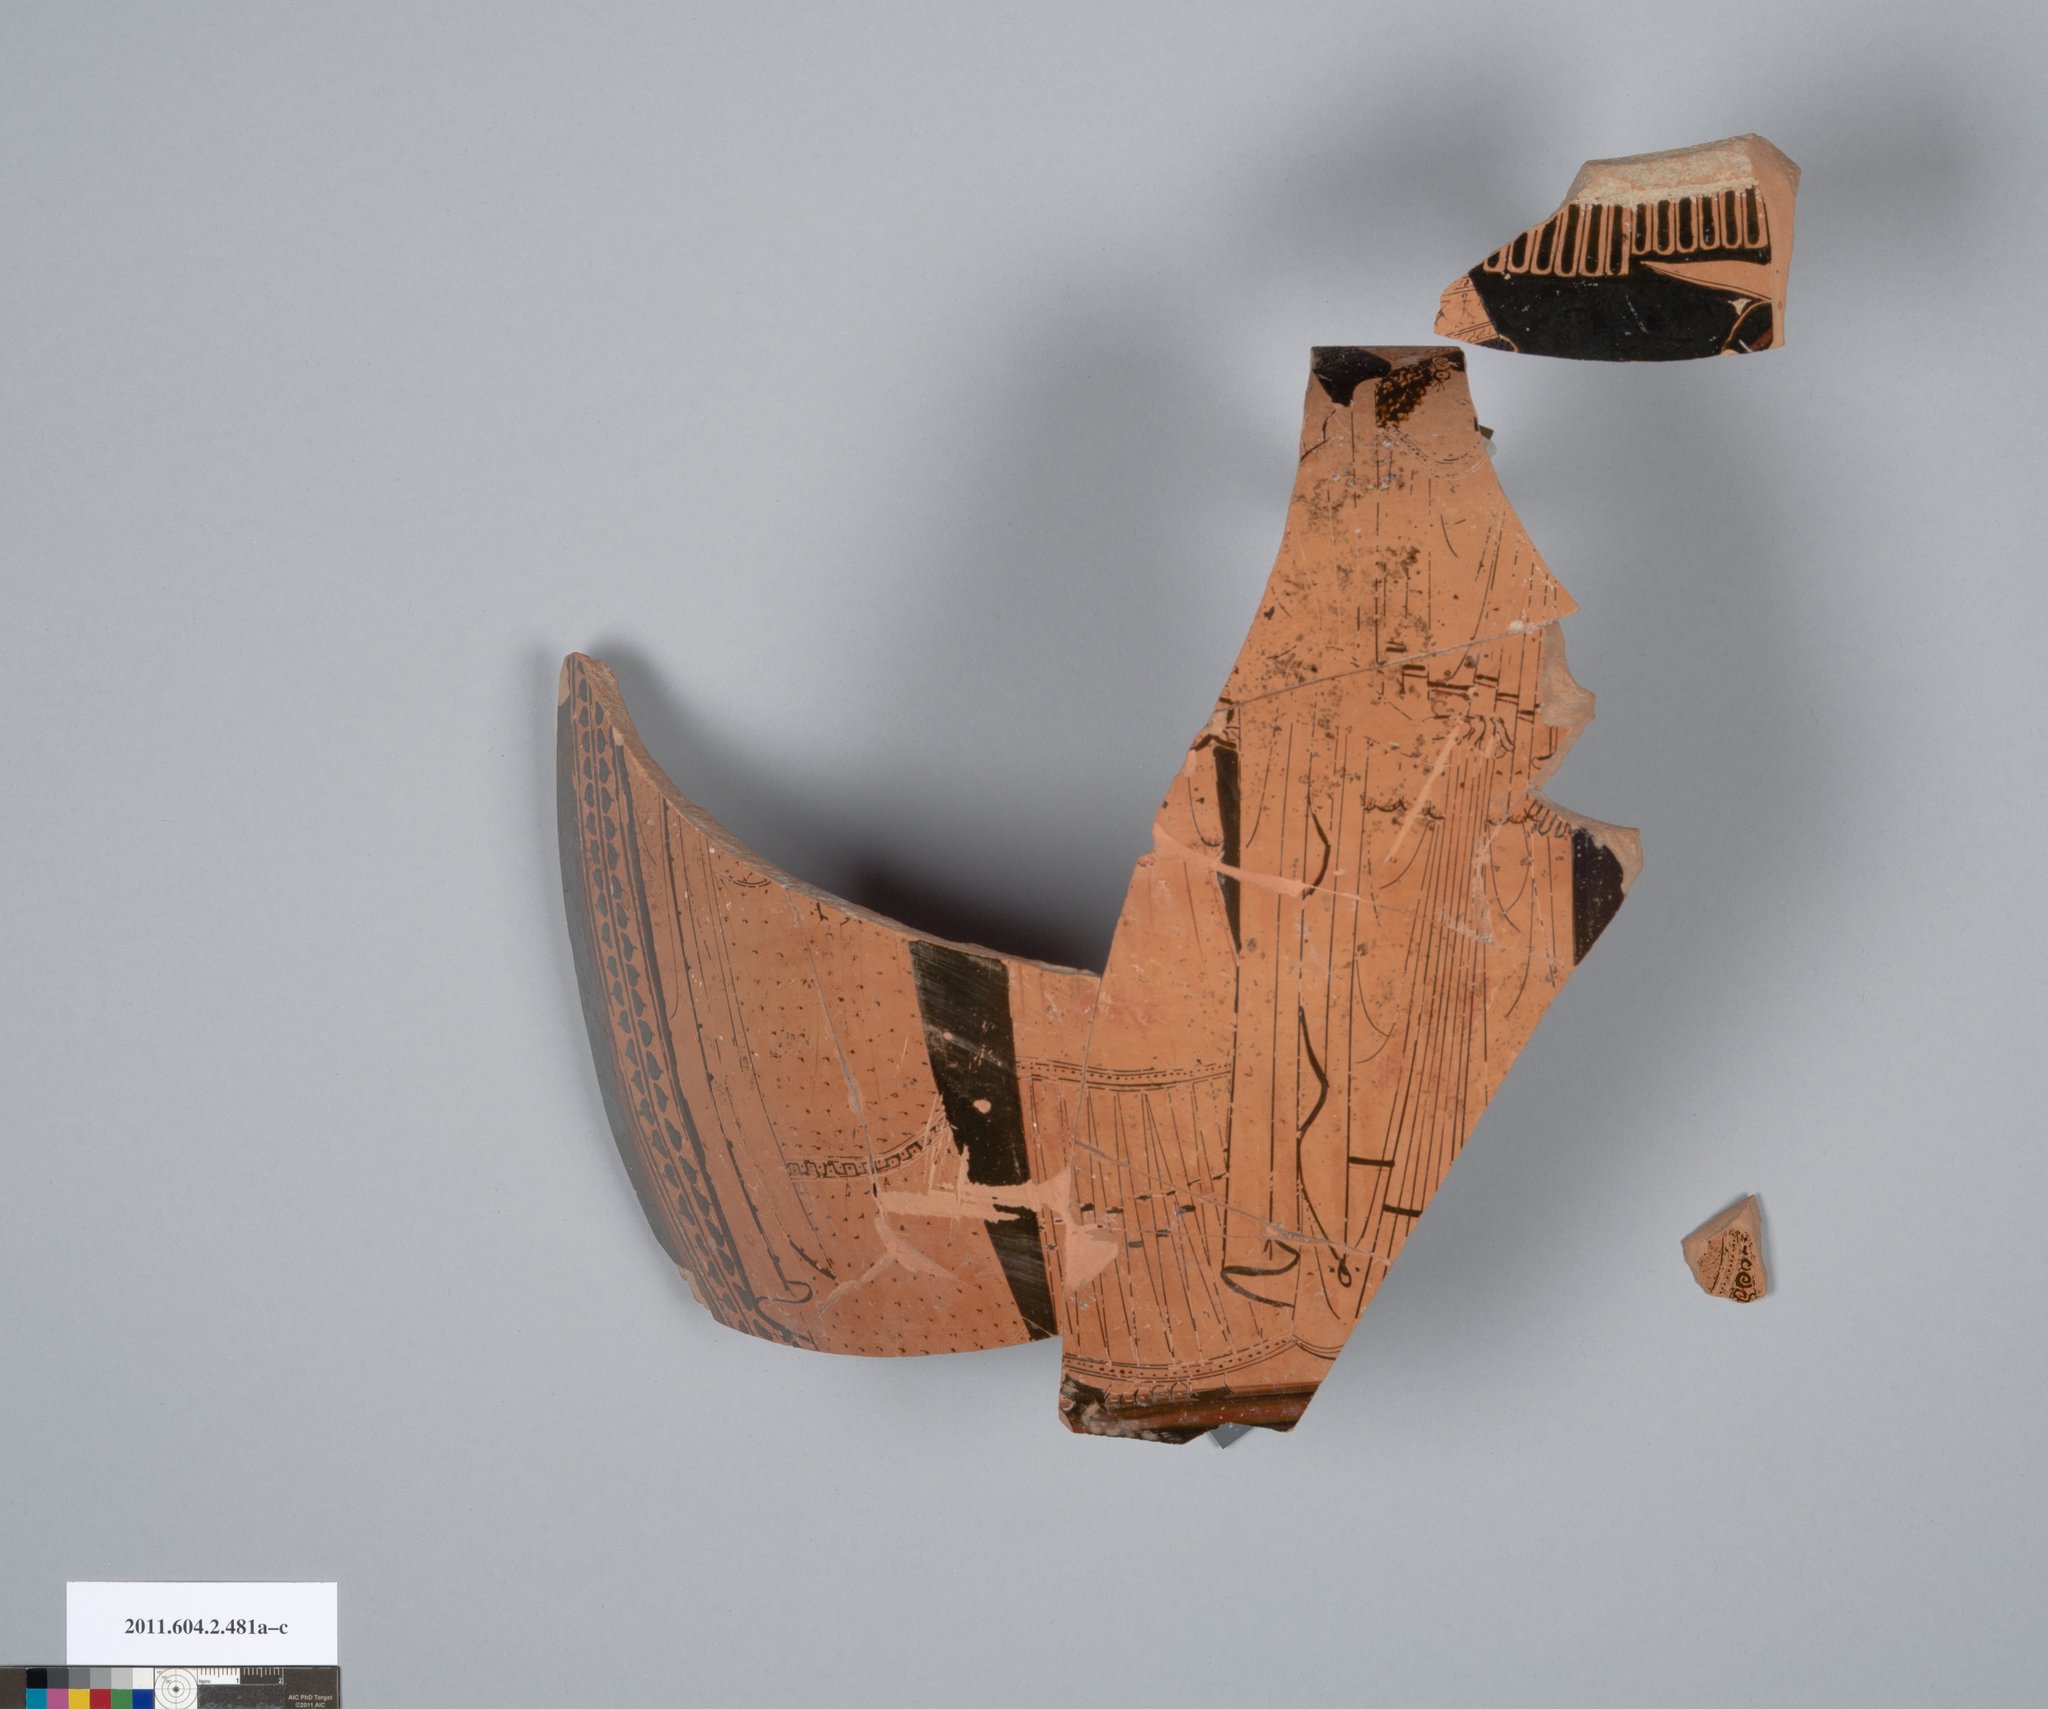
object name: column krater fragment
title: Terracotta fragments of a column-krater (bowl for mixing wine and water)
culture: greek, attic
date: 460-440 BCE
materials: terracotta